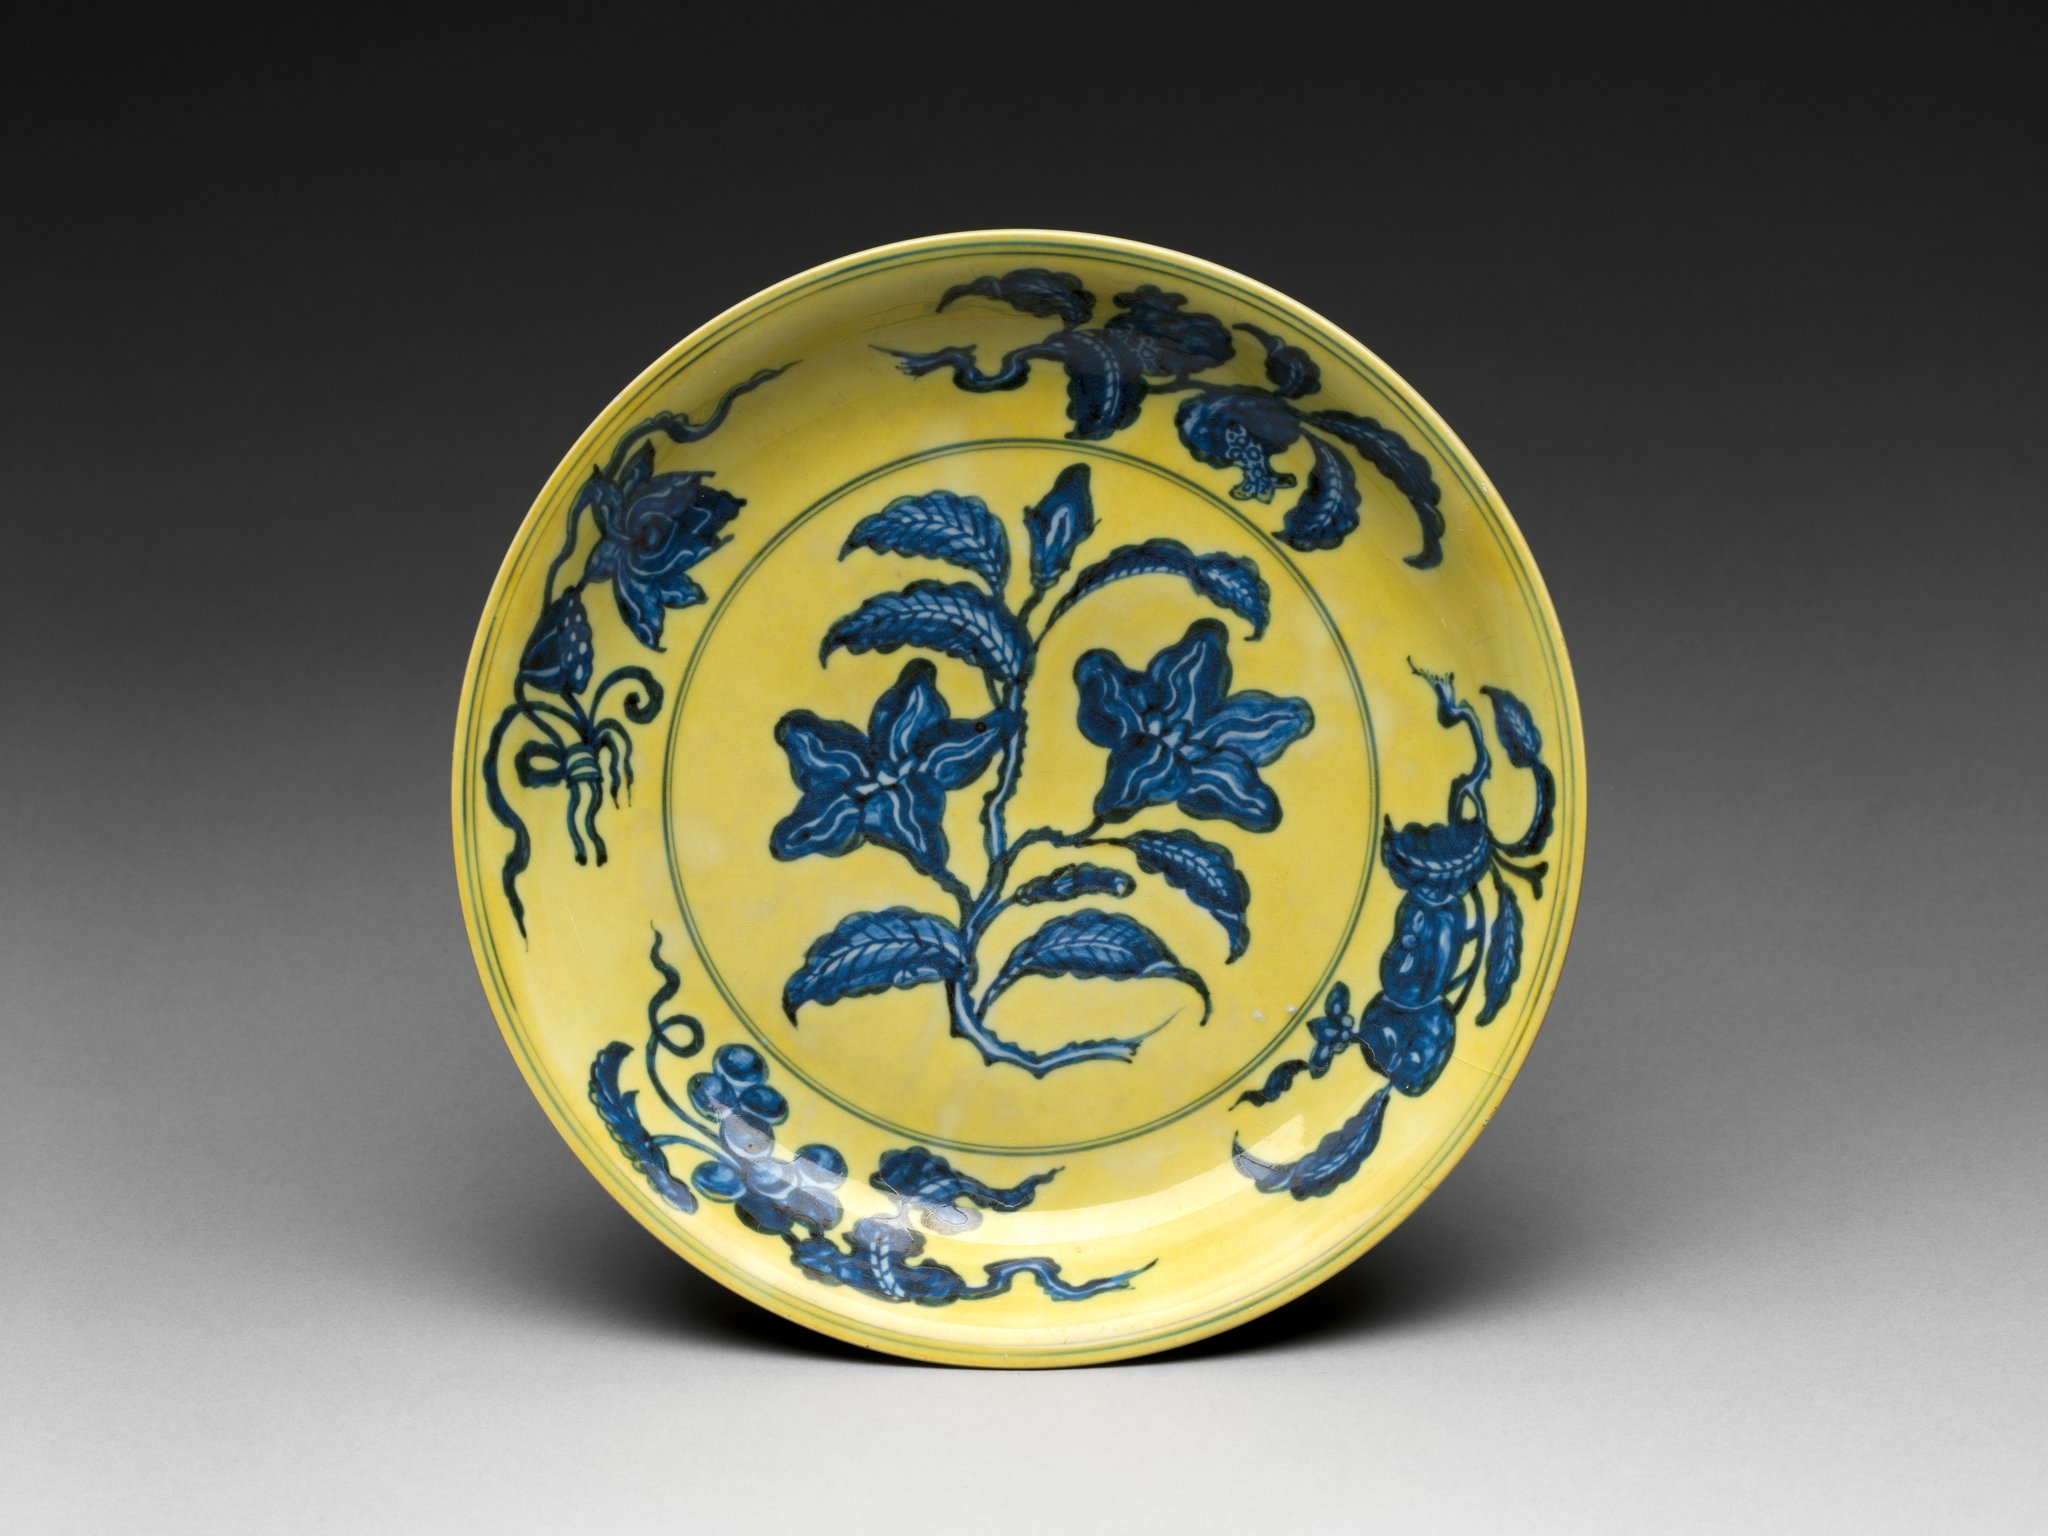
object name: dish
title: Dish with Gardenia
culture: chinese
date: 1567-1600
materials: cobalt, enamel, glaze, porcelain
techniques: painting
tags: flowers